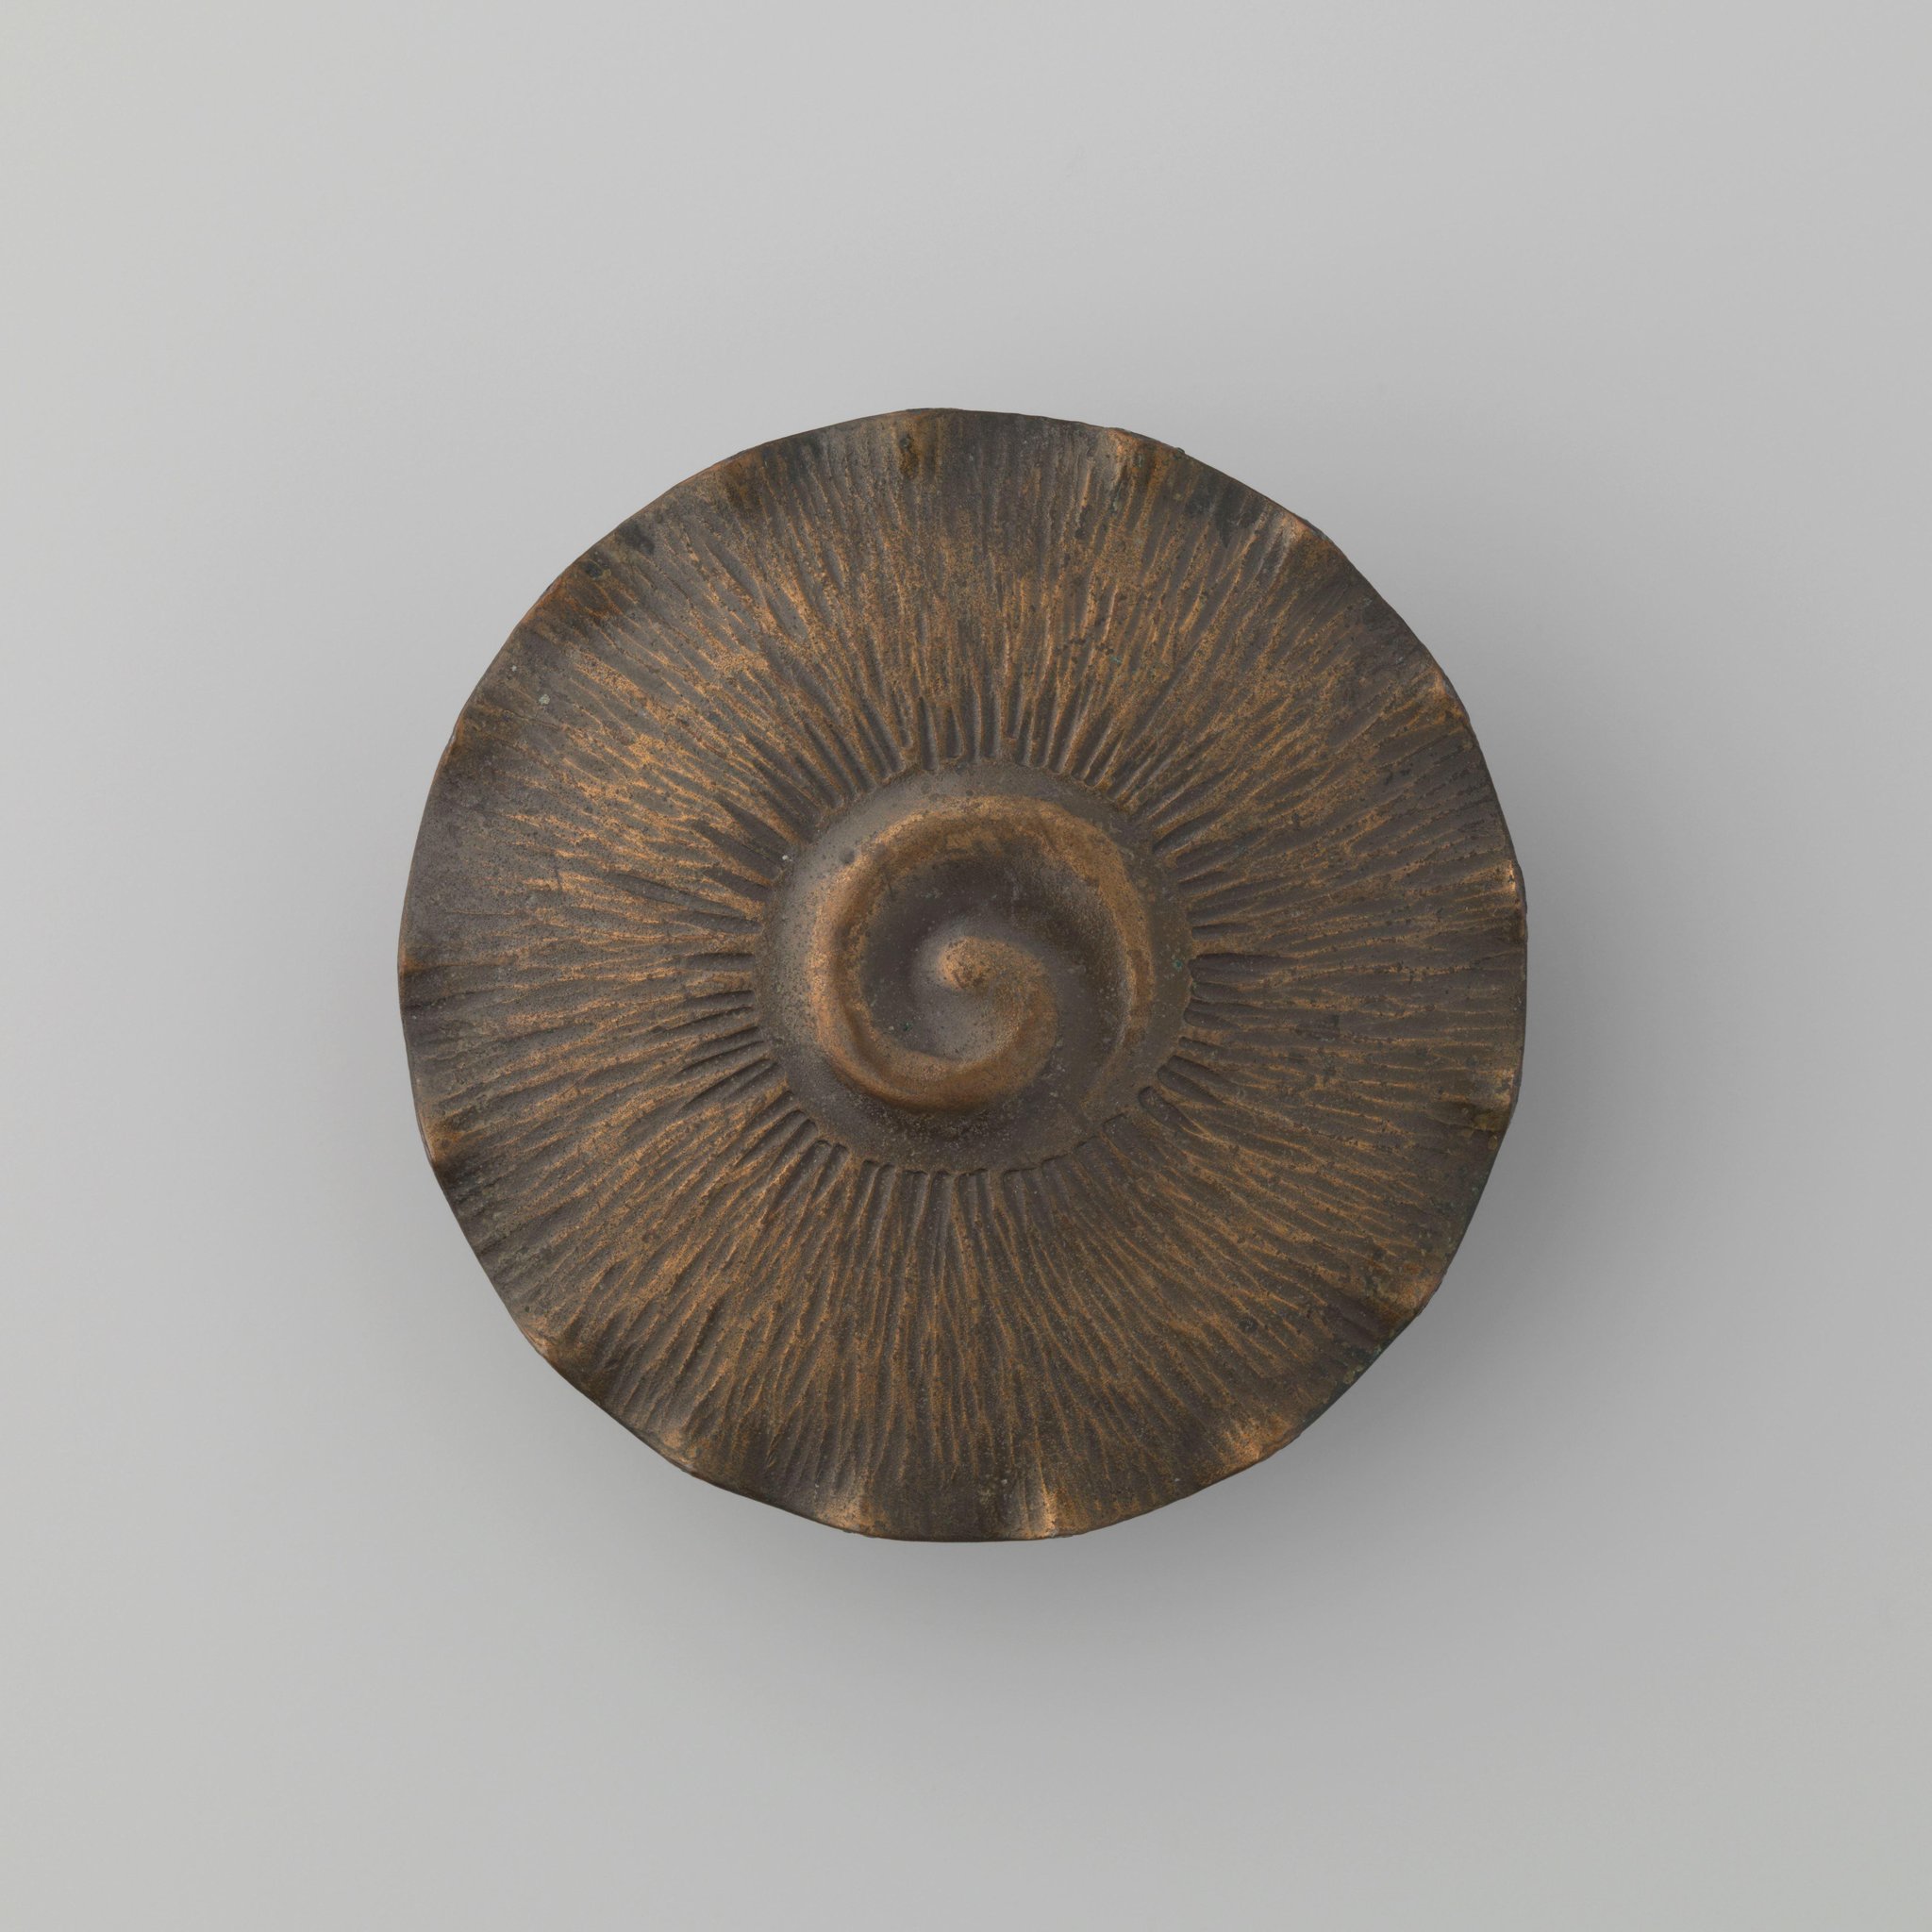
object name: brooch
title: Ronde broche van onedel goudkleurig metaal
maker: Anonymous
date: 1940-1945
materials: metal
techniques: hammering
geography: netherlands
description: Ronde broche van onedel goudkleurig metaal met een gehamerde rand en een spiraalvorm in het midden.